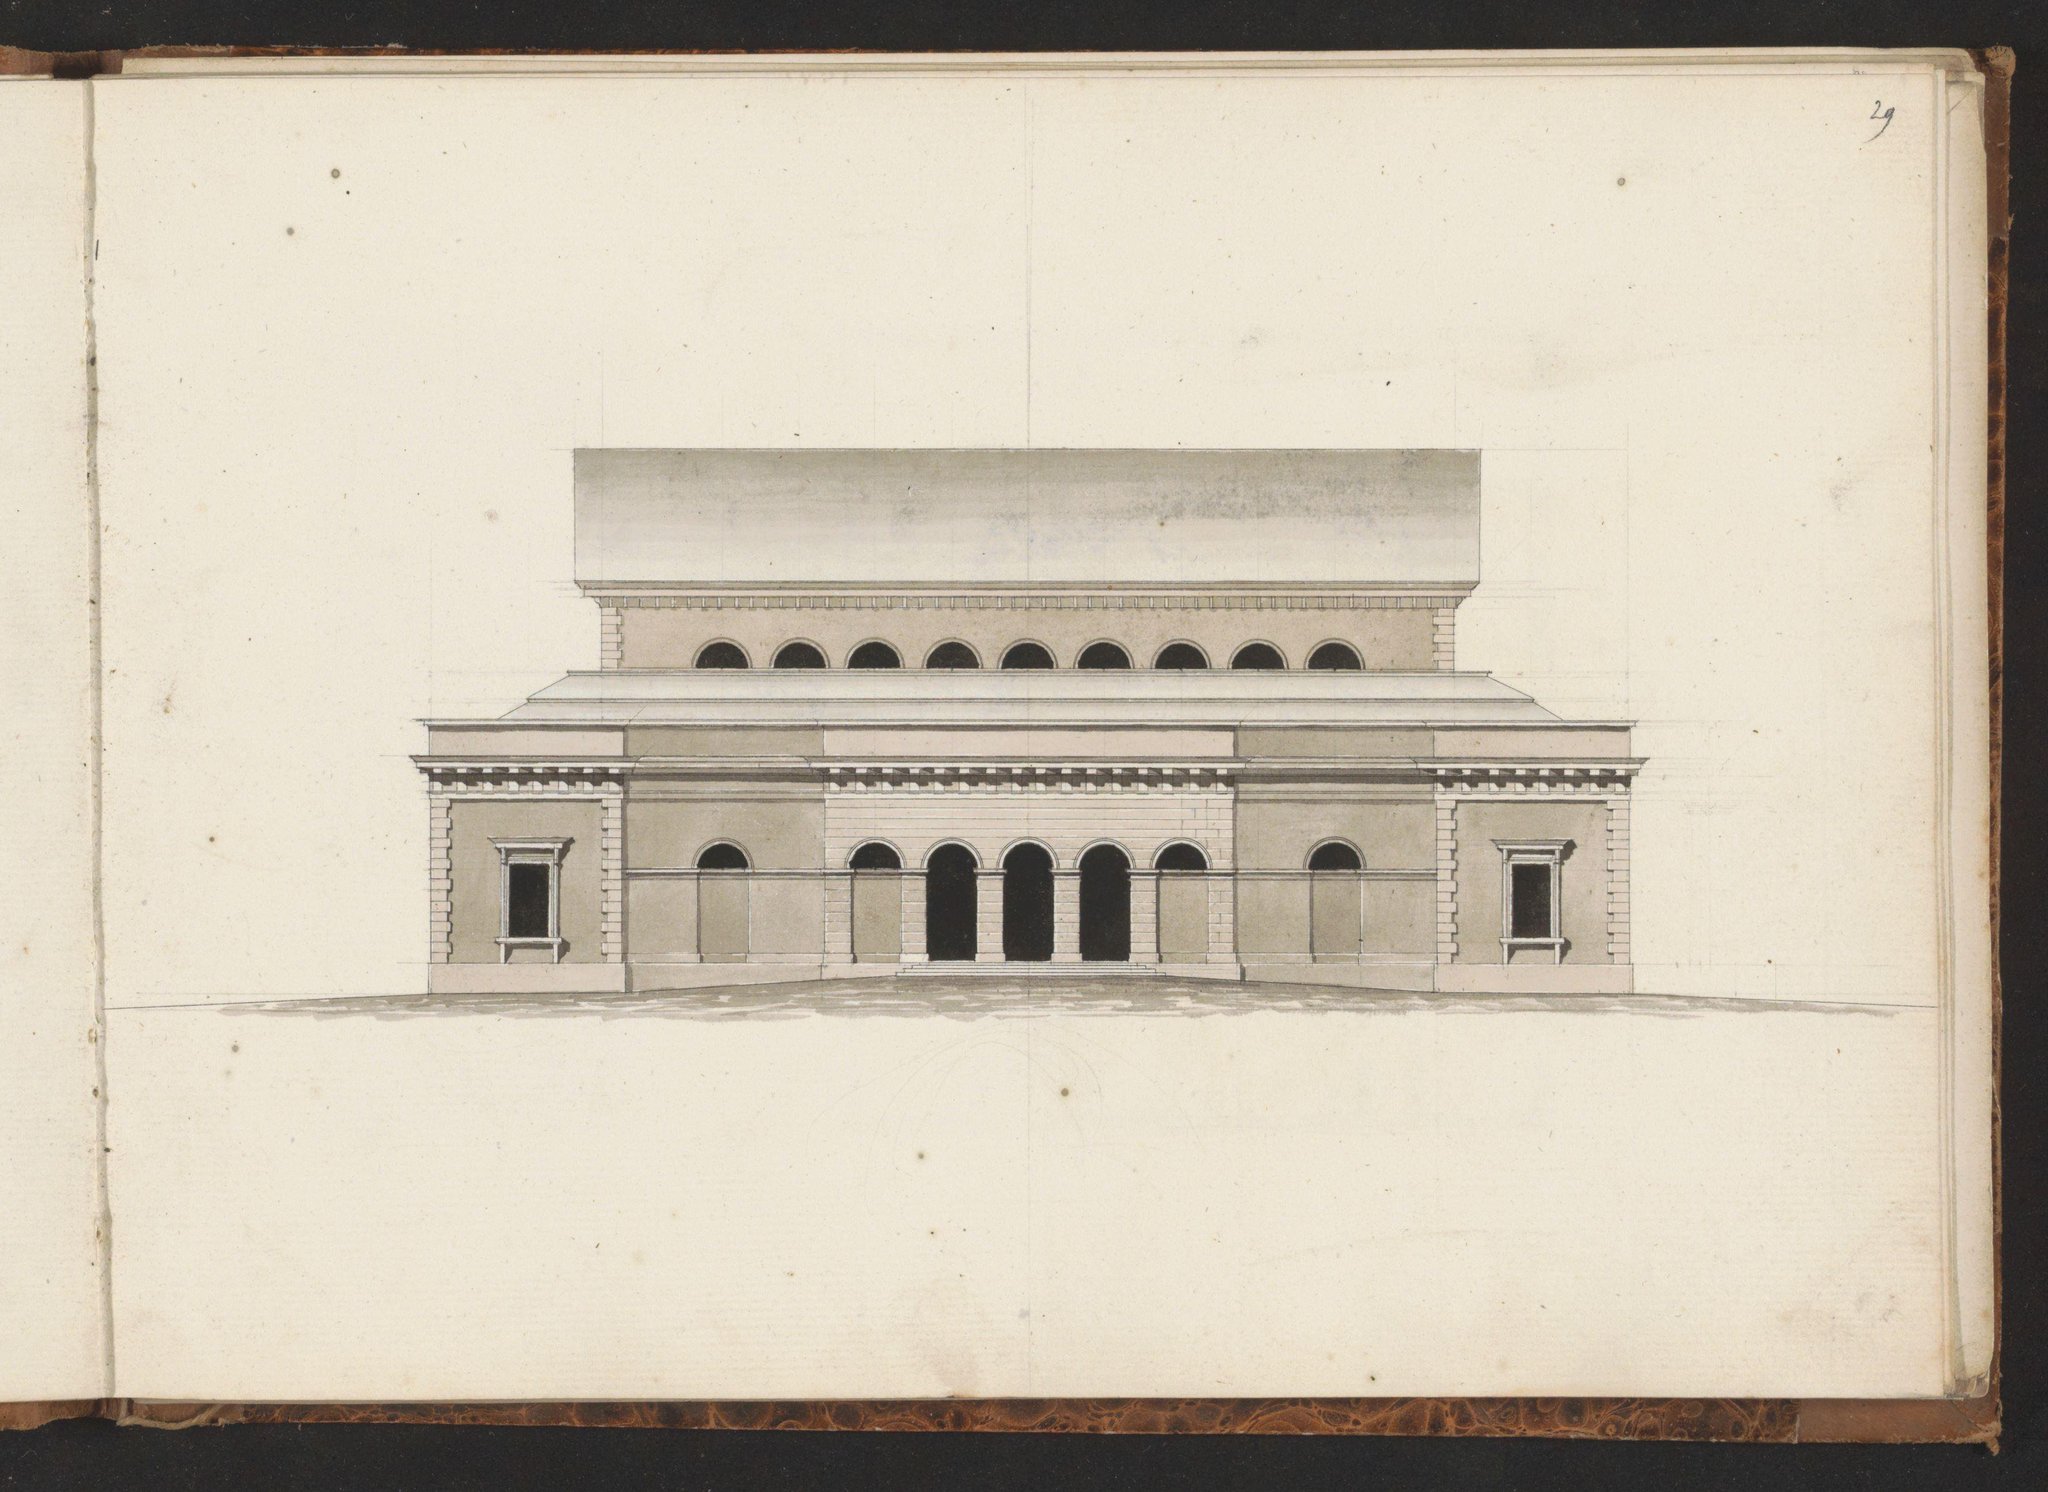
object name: sketchbook leaf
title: Voorgevel van een villa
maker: willem springer jr.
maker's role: draughtsman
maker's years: 1815-1907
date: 1825-1907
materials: ink, paper, pencil, watercolor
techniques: brush, pen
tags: villa, façade (of house or building)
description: Pagina 29 uit een schetsboek met 86 pagina's.